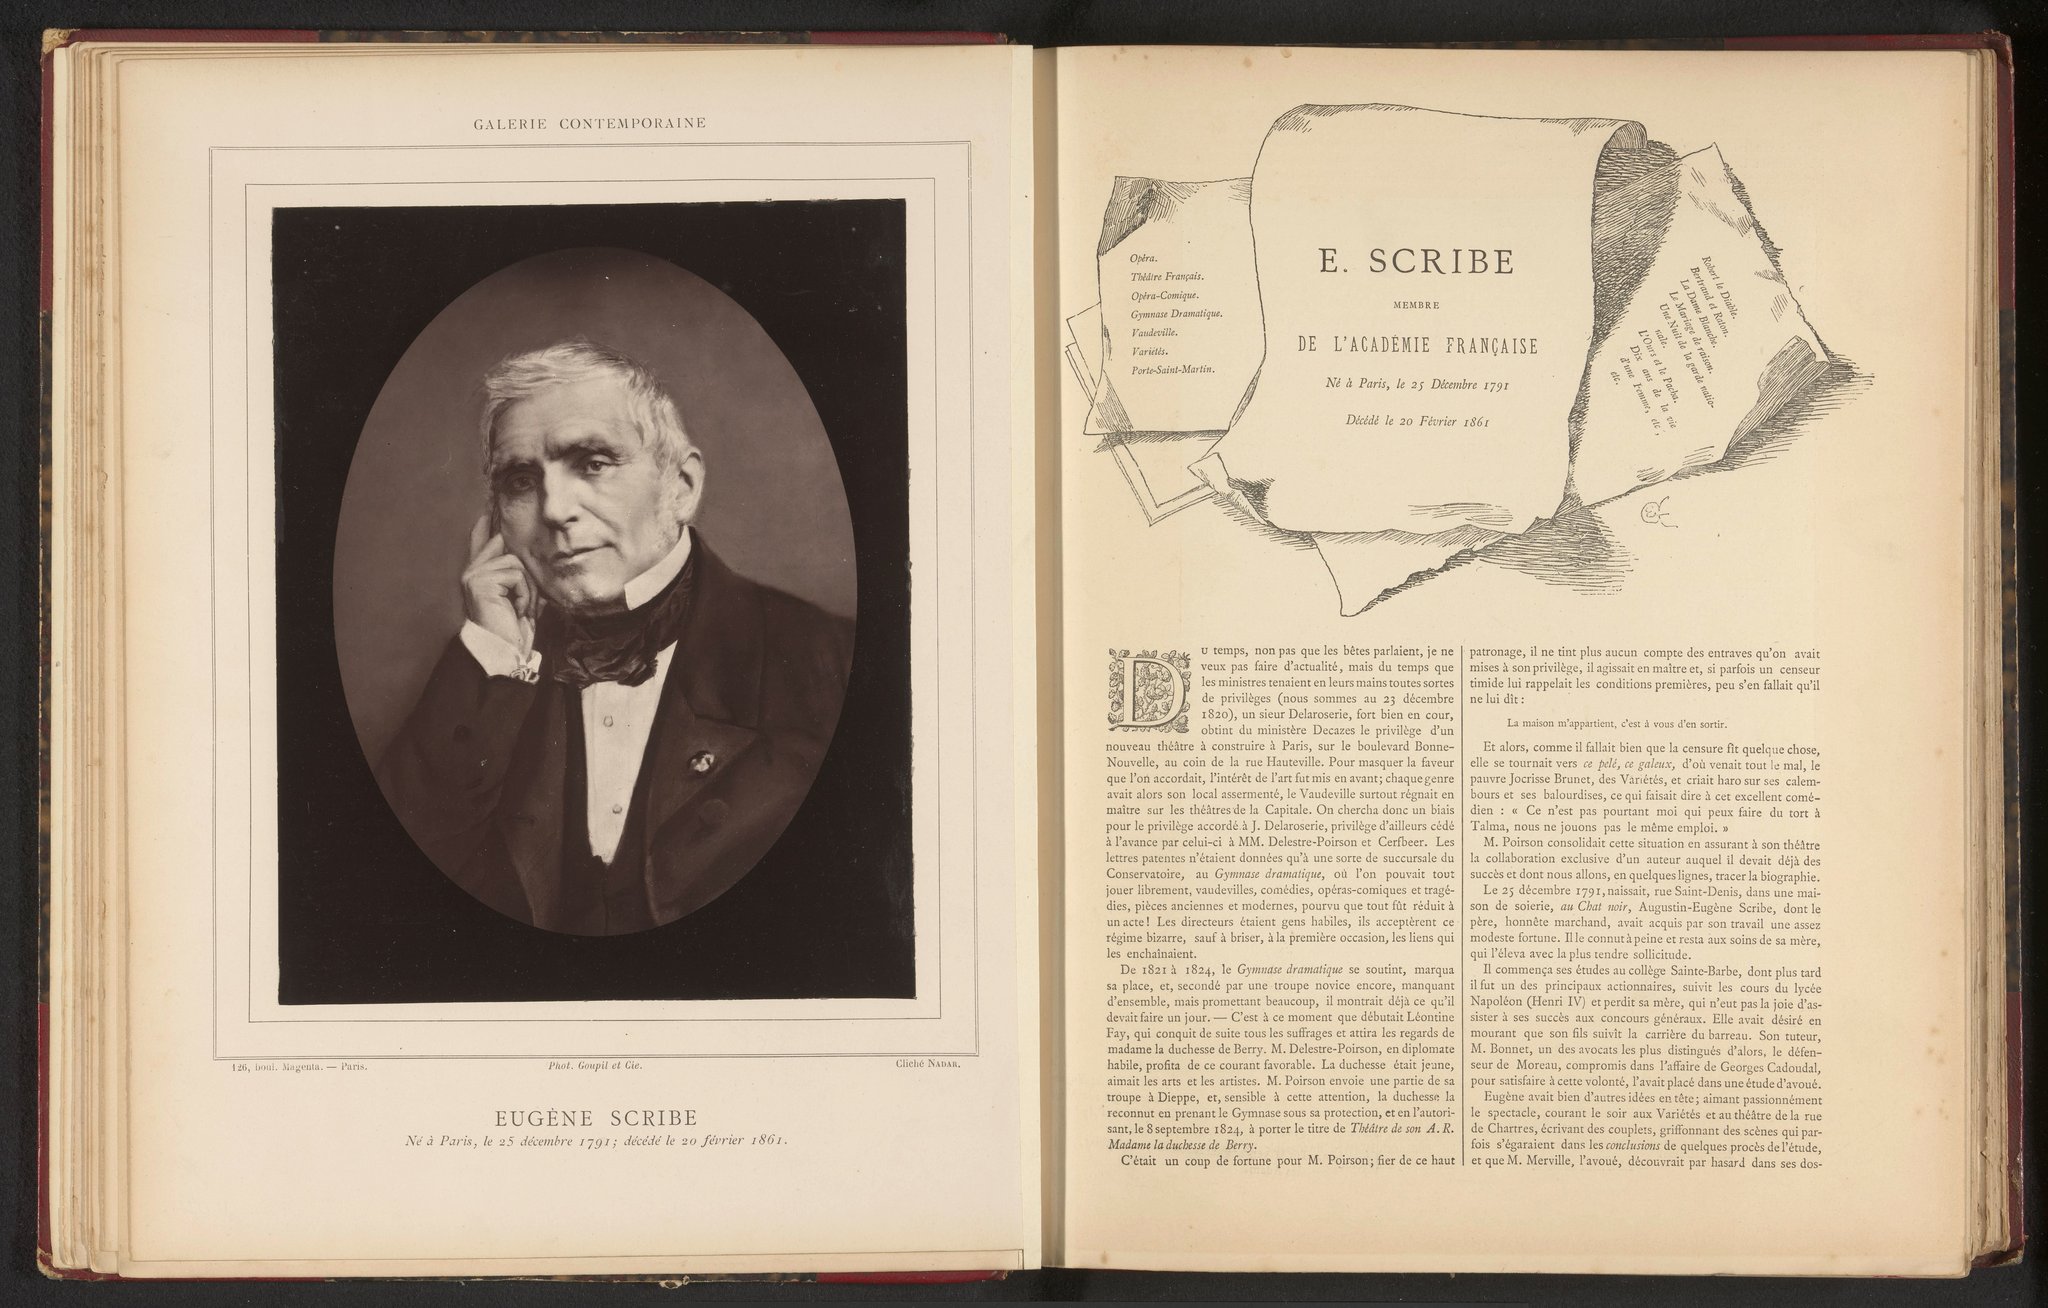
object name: page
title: Eugene Scribe. Ne a Paris, le 25 decembre;decede le 20 fevrier 1861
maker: félix nadar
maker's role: ballonvaarder, fotograaf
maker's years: 1820-1910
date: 1850-1861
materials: paper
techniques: woodburytype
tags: portrait of a writer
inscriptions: inscription: ‘126, boul. Magenta.-Paris.’